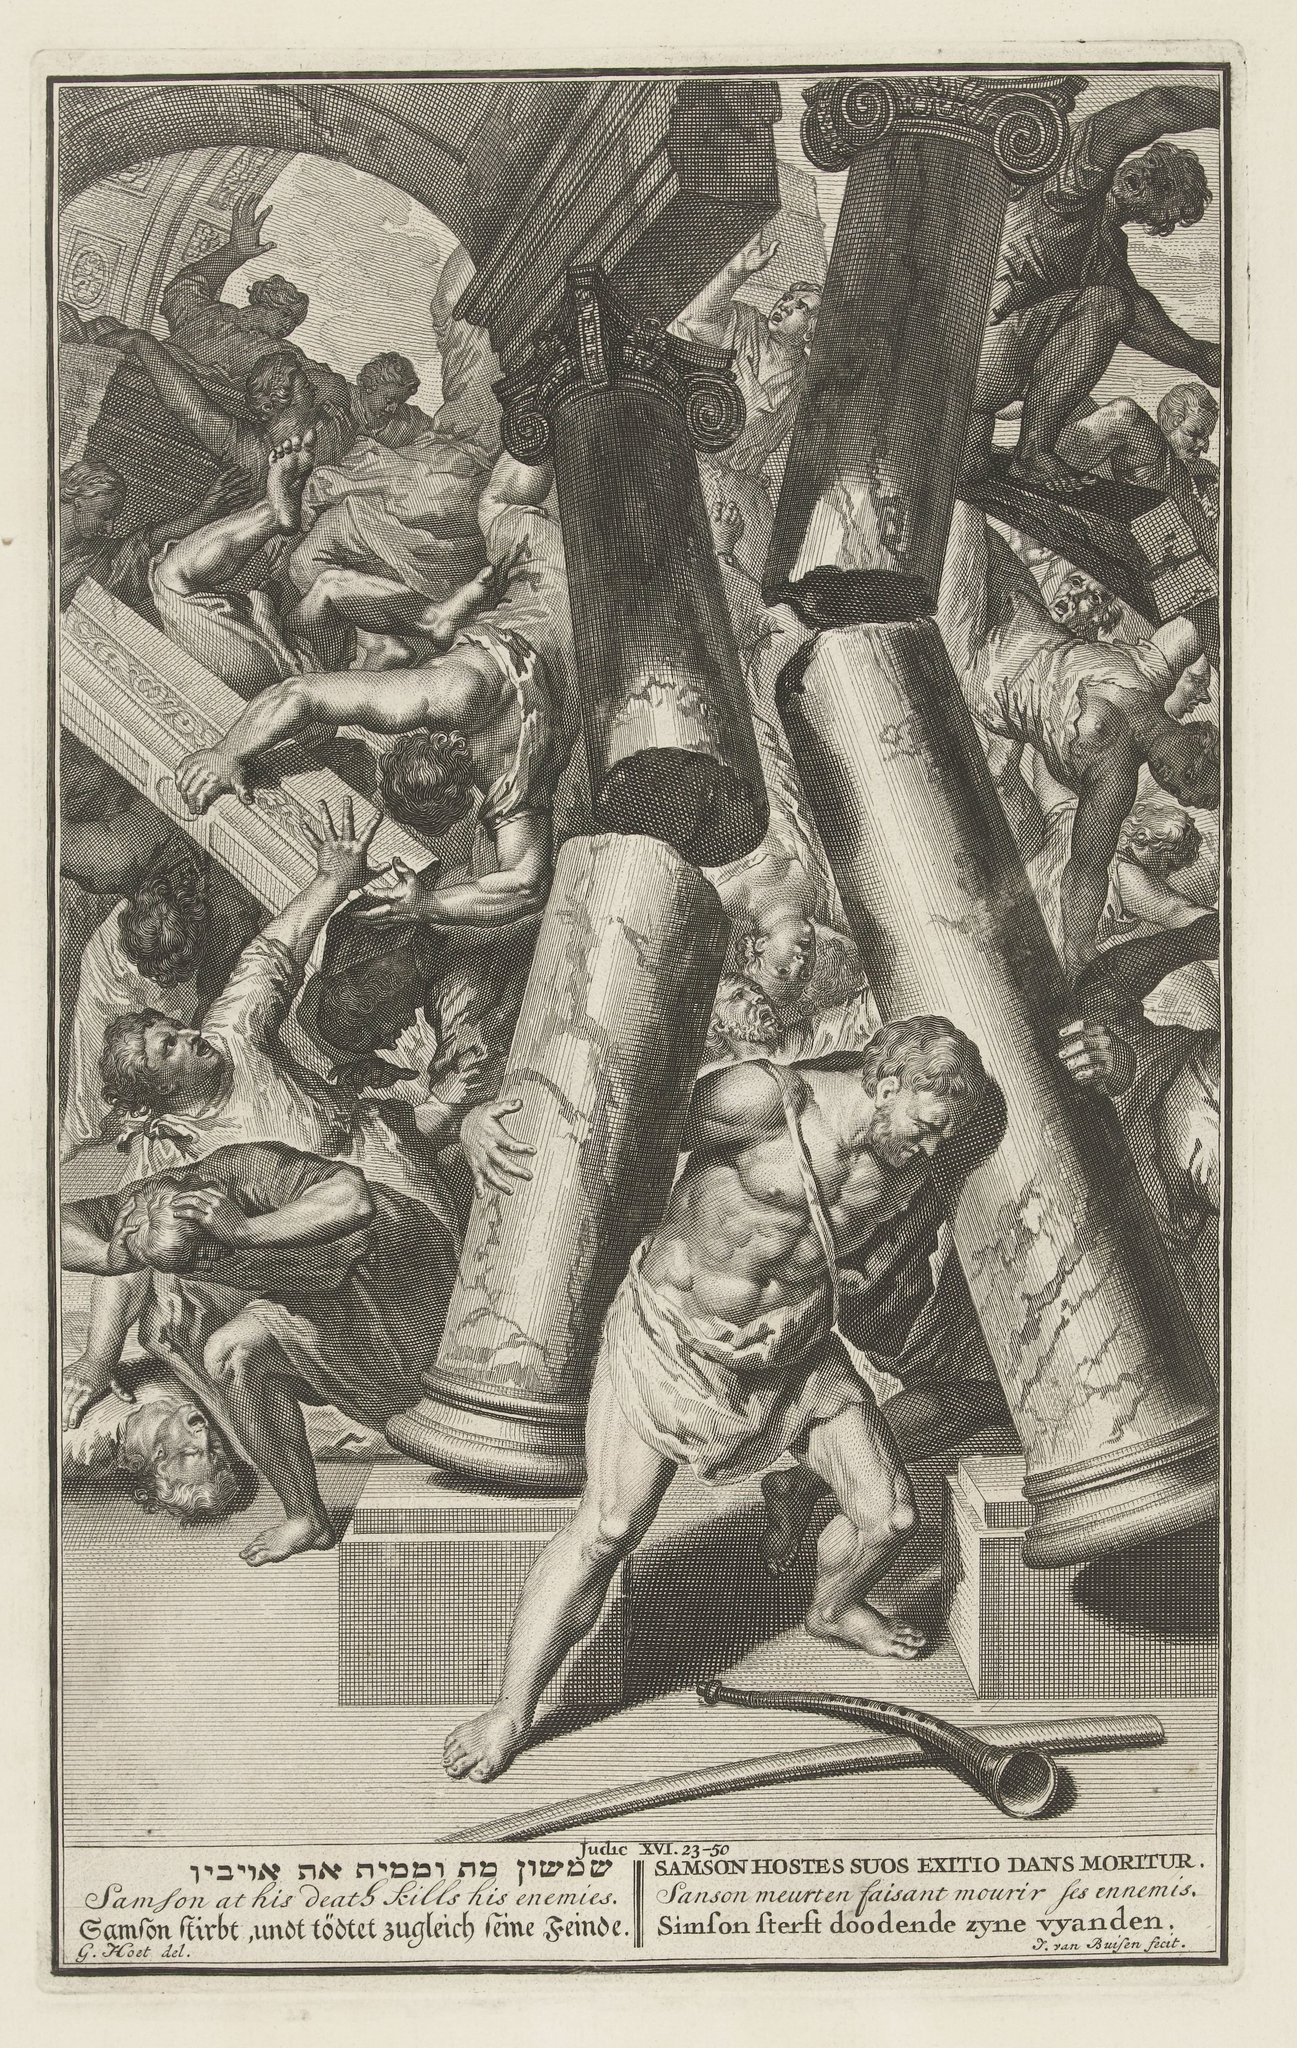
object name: print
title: Simson vernielt de zuilen van de tempel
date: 1711-1720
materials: paper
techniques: engraving, etching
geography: amsterdam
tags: samson breaks the pillars; the temple of dagon collapses, killing all that are in it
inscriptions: collector's mark: Lugt 2228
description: Simson vernielt met zijn laatste krachten de zuilen van de tempel en doodt zo zichzelf en de aanwezige Filistijnen. Illustratie voor het Oude Testament, Recht. 16: 23-25. Onder de voorstelling een titel in het Hebreeuws, Engels, Duits, Latijn, Frans en Nederlands.